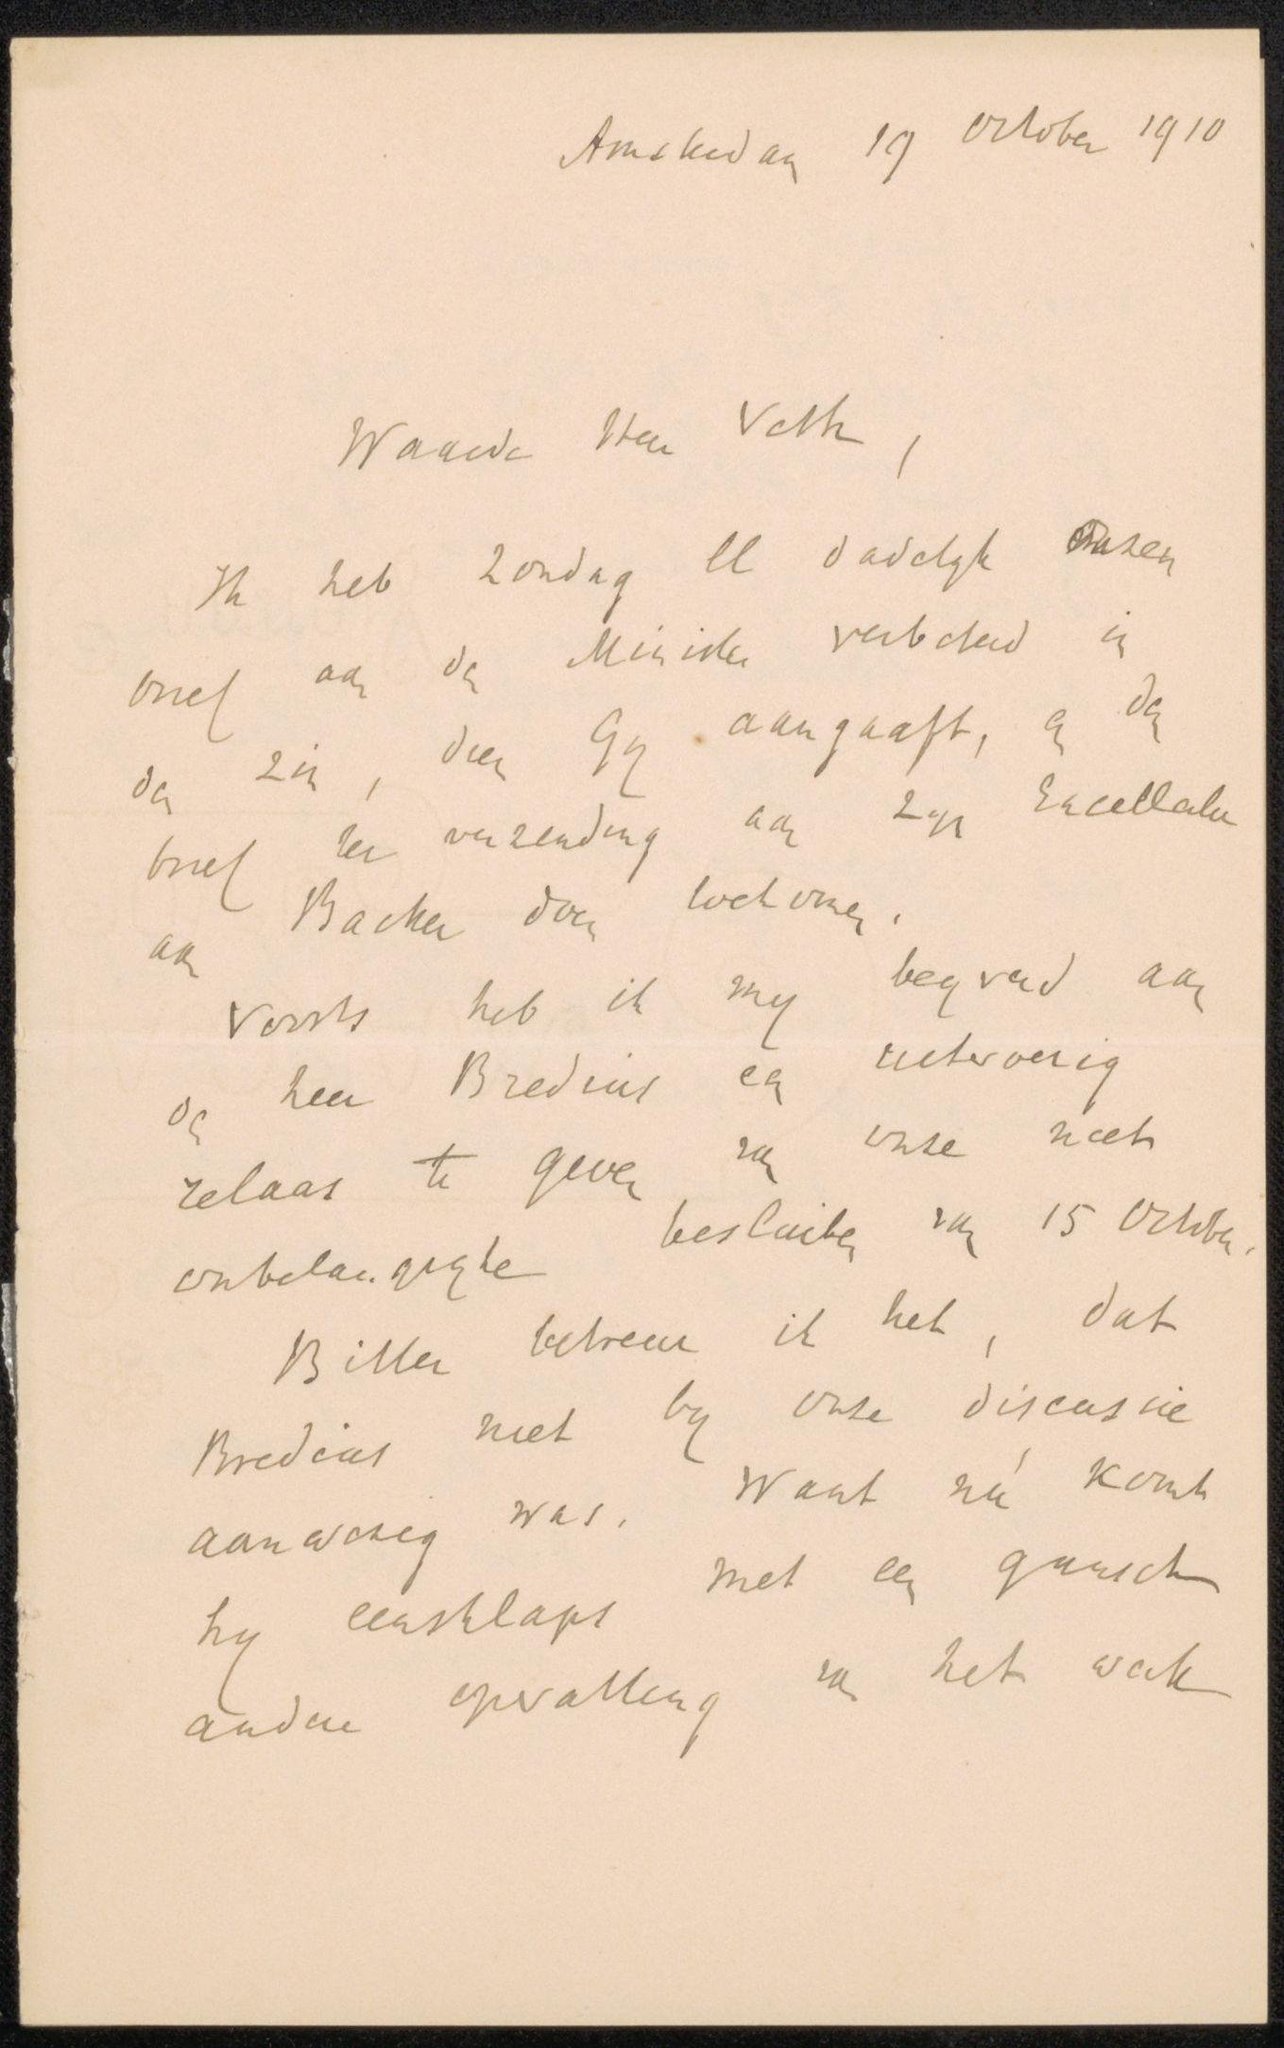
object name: letter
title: Brief aan Jan Veth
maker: hendrick peter godfried quack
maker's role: econoom, geschiedschrijver, hoogleraar, jurist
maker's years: 1834-1917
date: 1910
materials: ink, paper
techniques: pen, writing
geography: amsterdam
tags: dordrecht, painter, draughtsman, designer, jan veth, abraham bredius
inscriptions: watermark, collector's mark: ‘RPK’